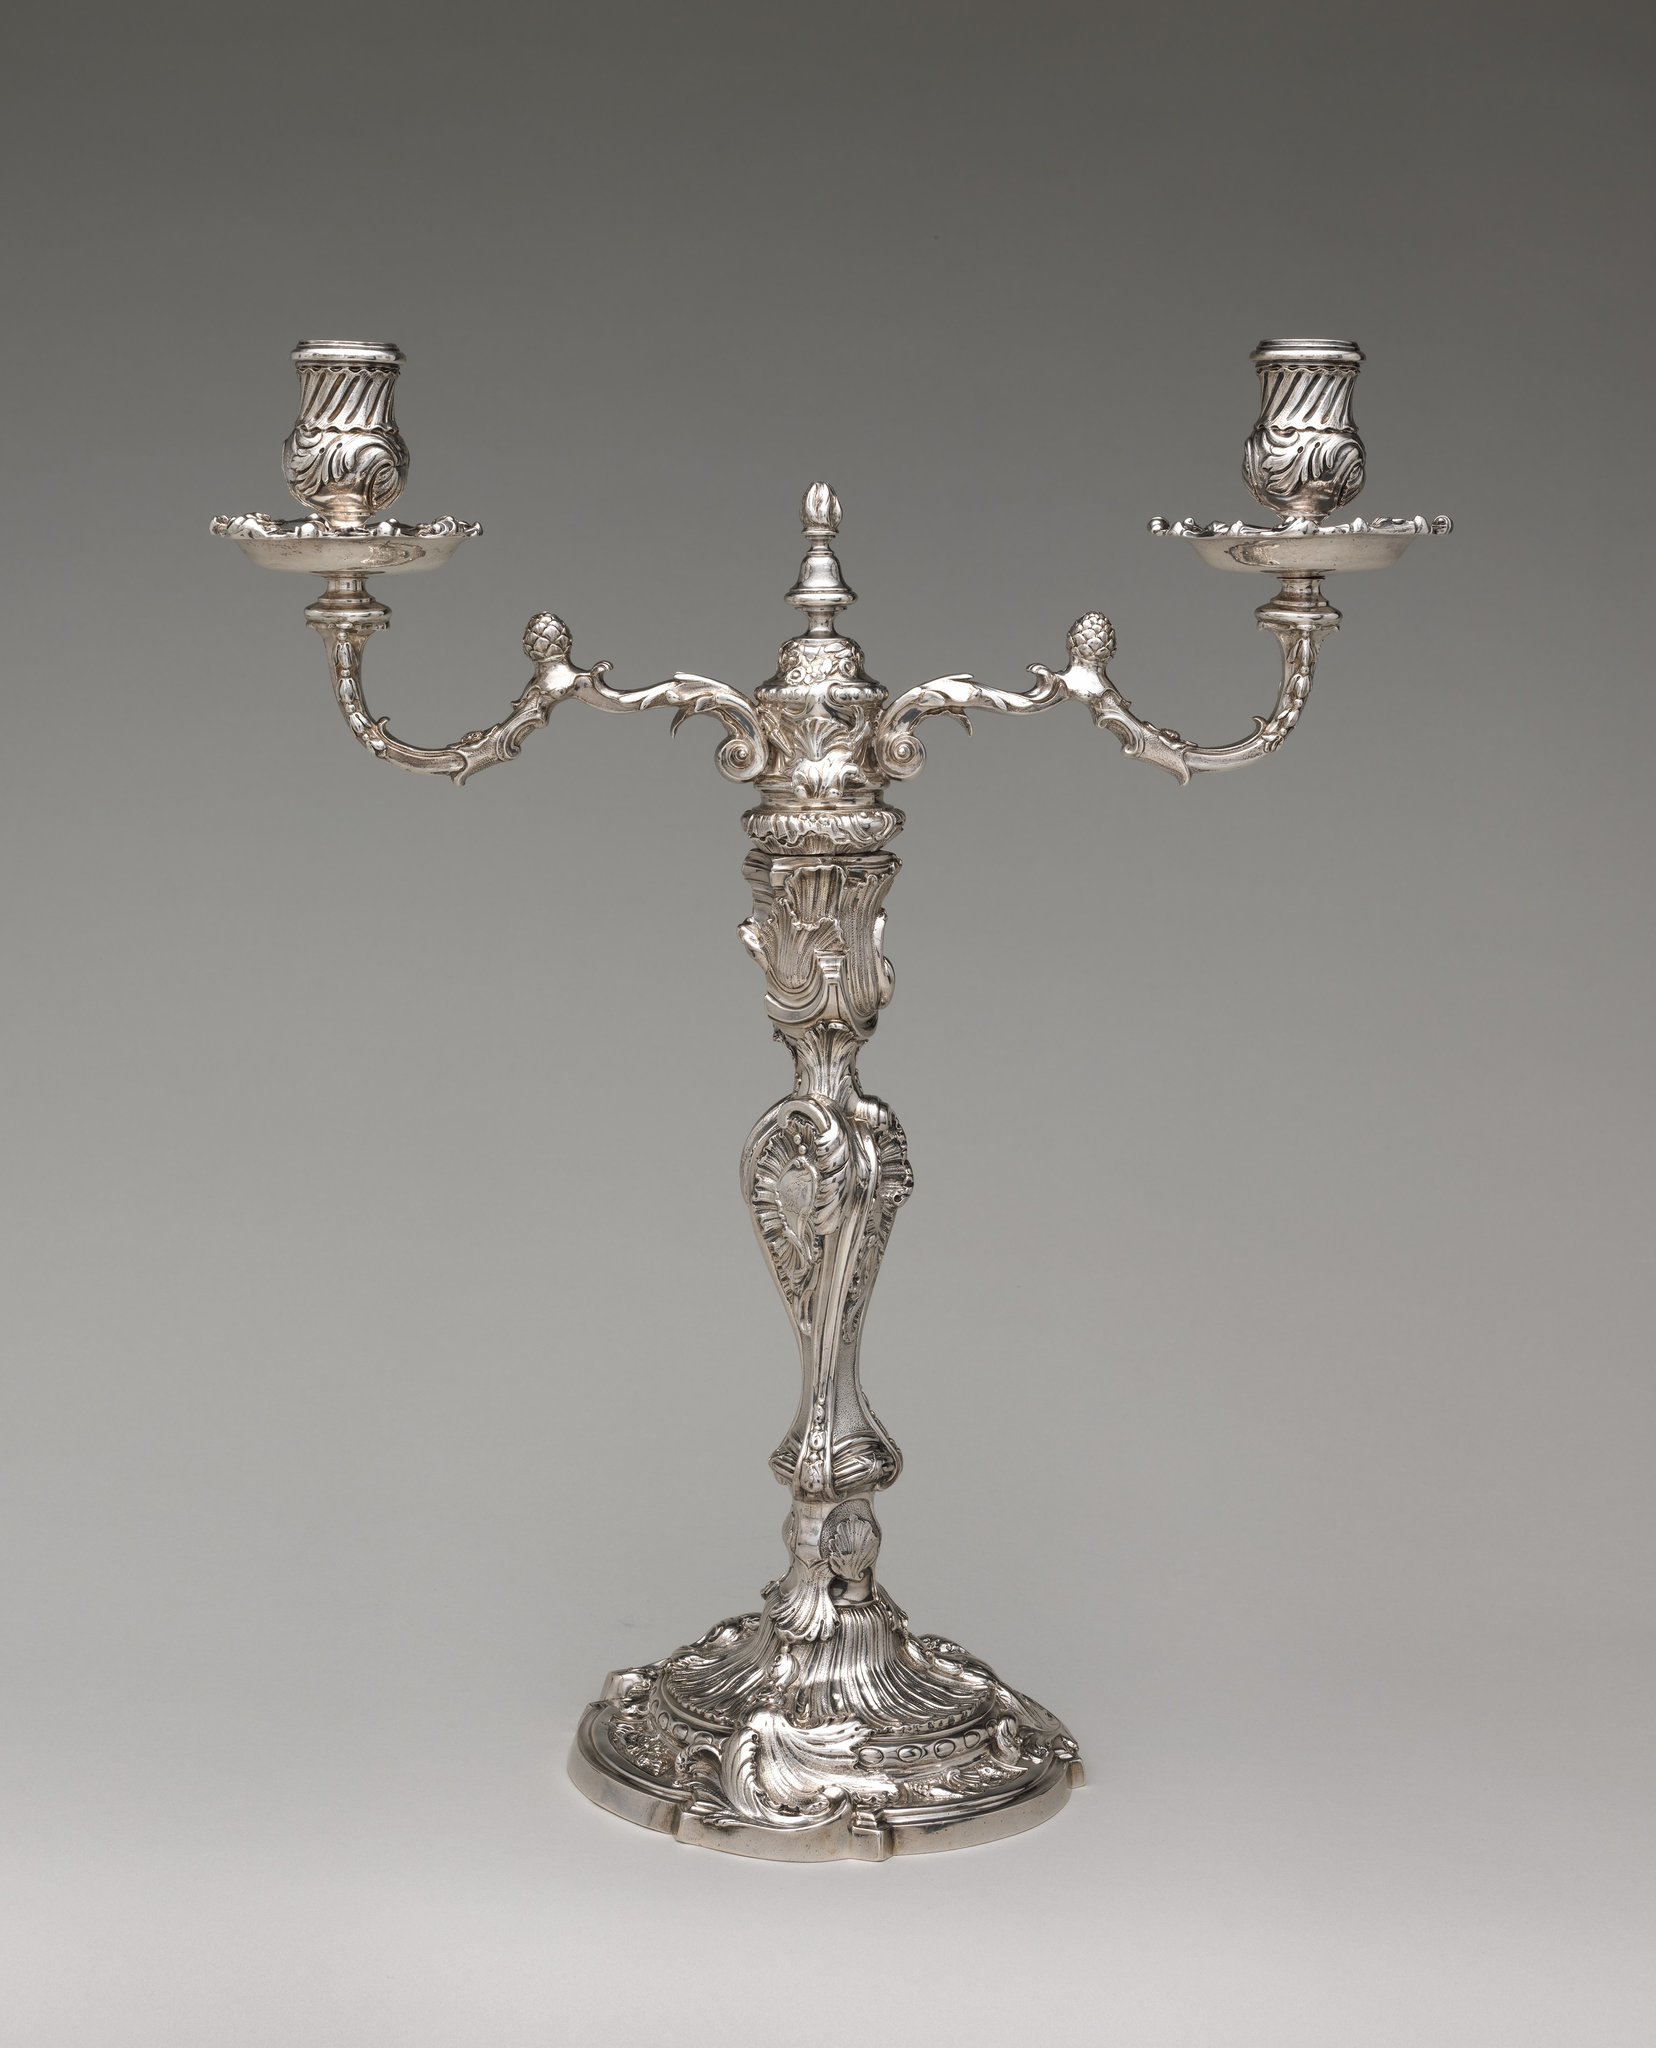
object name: candelabrum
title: Candelabrum (one of a pair)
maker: david willaume ii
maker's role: maker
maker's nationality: british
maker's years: 1693-1761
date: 1742-1743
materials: silver